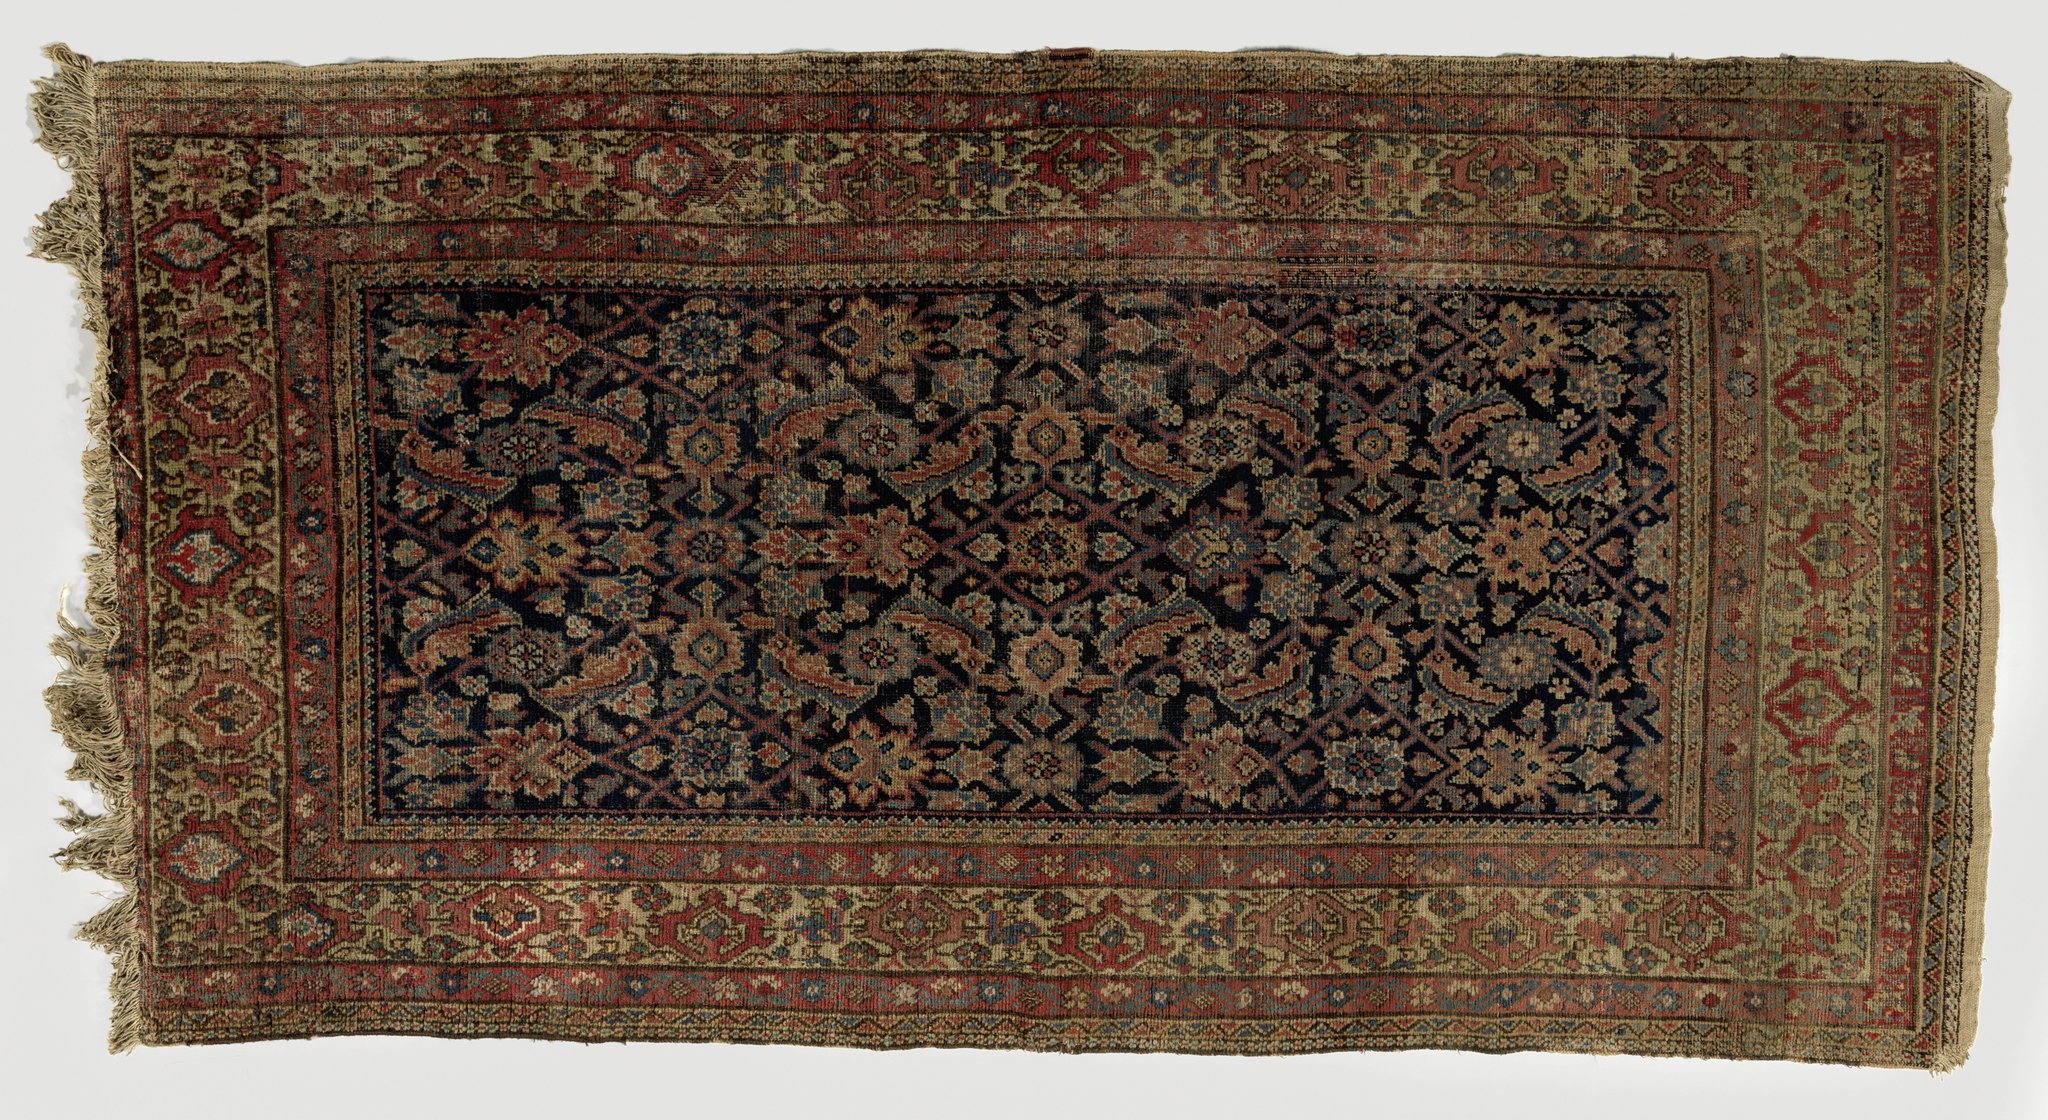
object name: oriental rug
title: Oosters tapijt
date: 1875-1900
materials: cotton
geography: central persia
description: Oosters tapijt, bloemenkleed. In het middenveld een herati-patroon tegen een donkerblauwe achtergrond. Veelvoudige rand, waarvan de breedste versierd is met bloemen.